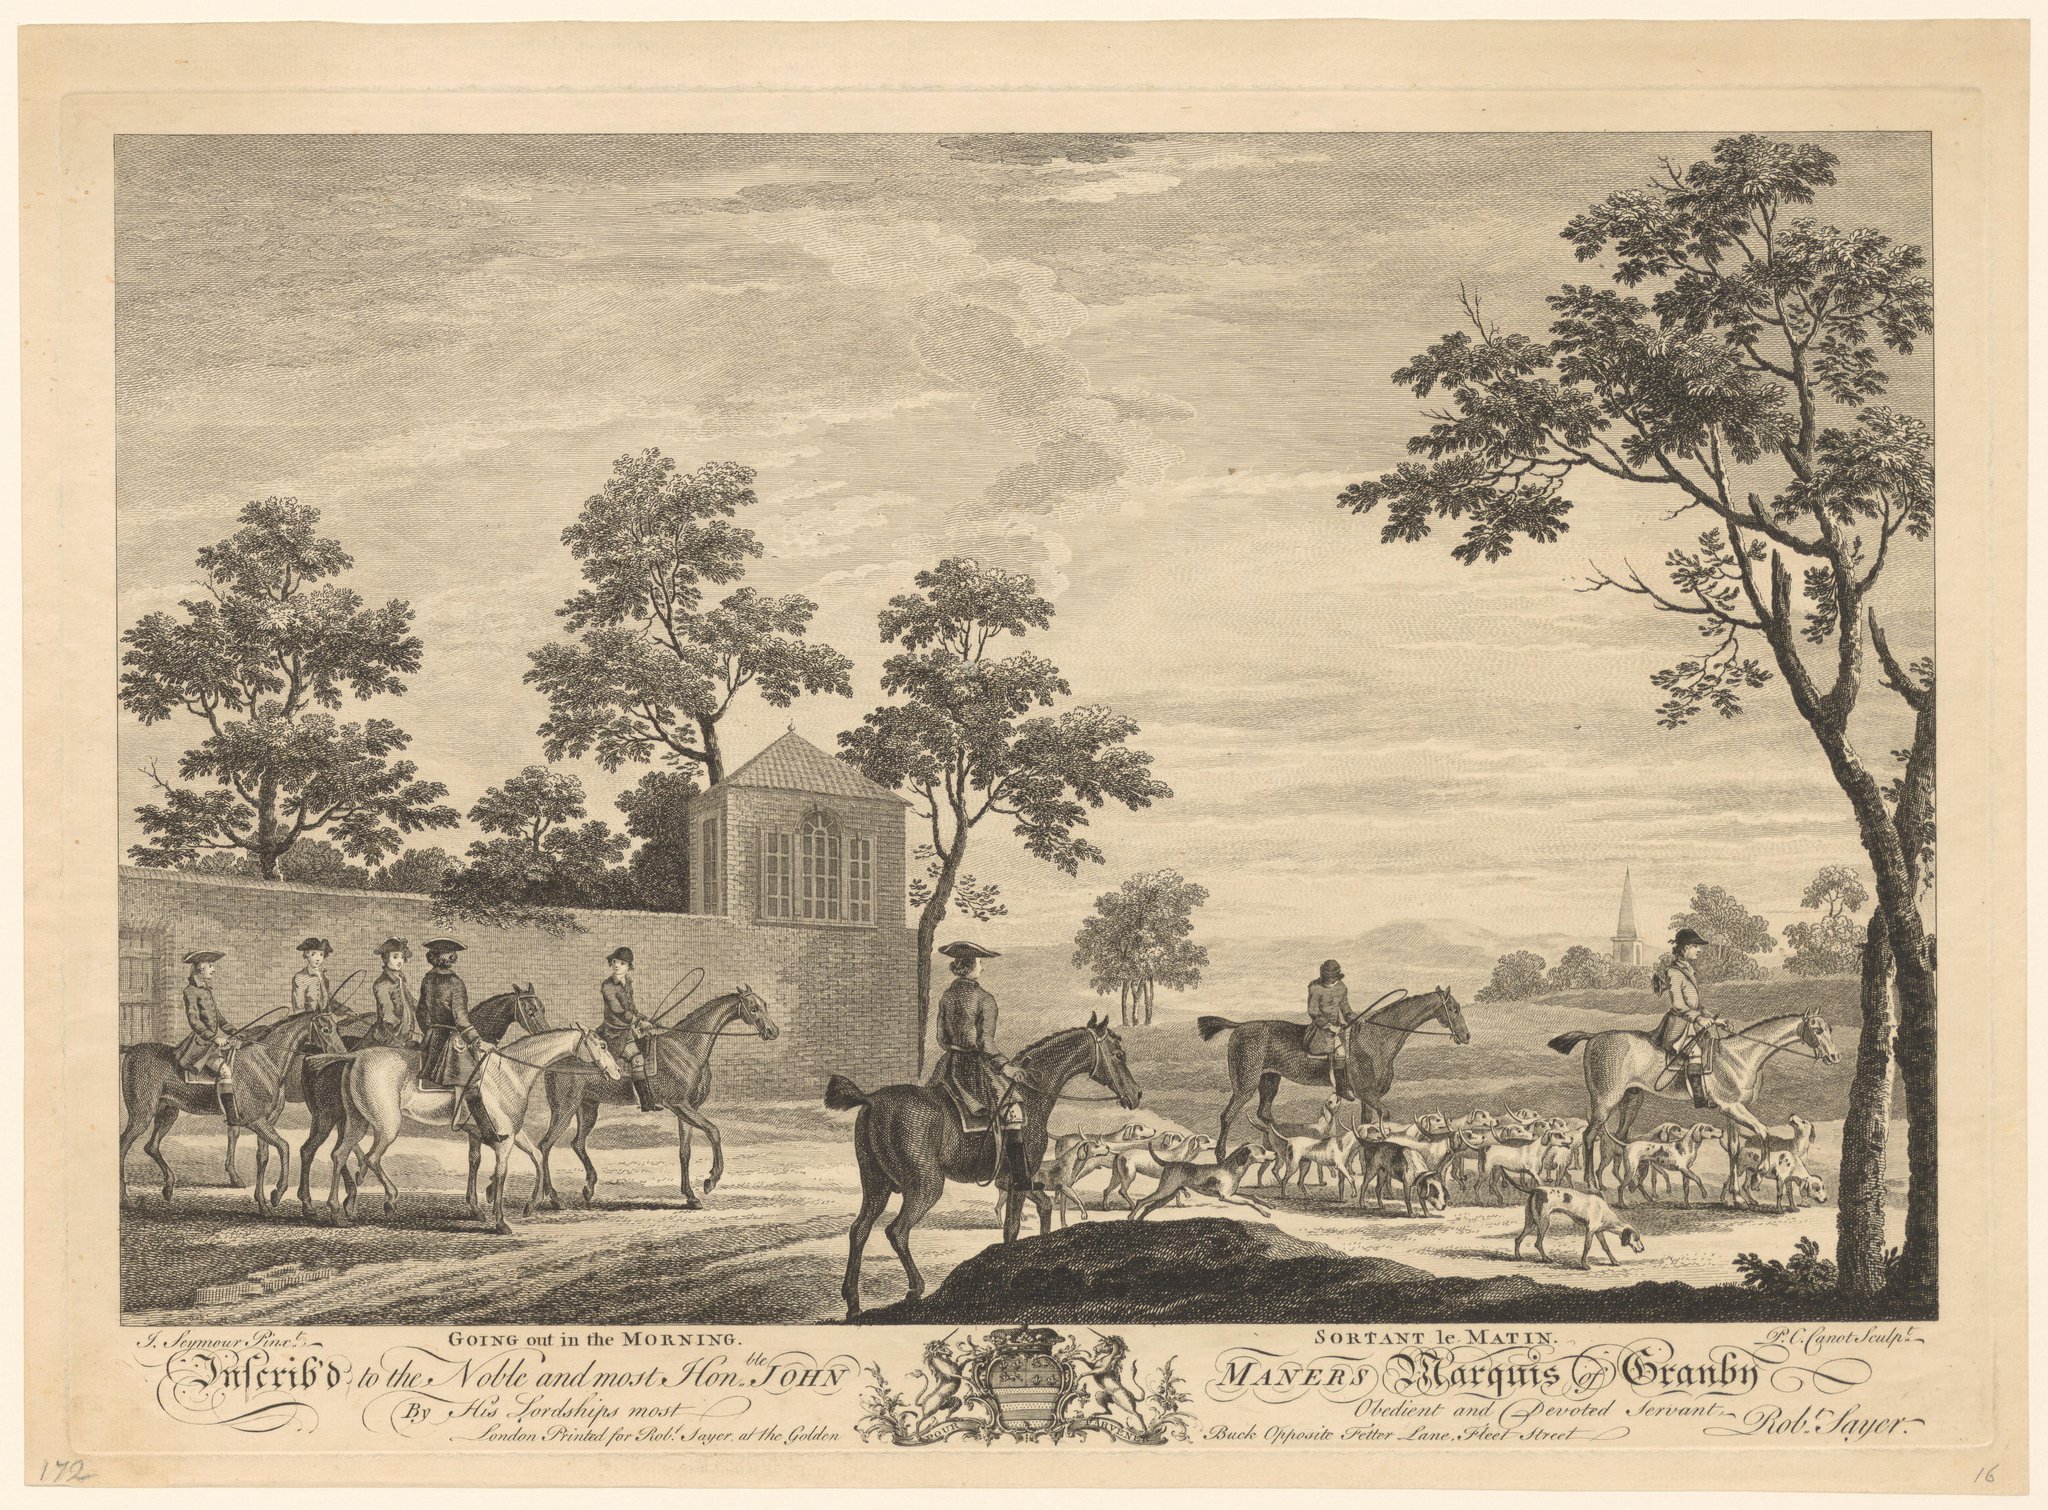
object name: print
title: Going out in the Morning / Sortant le Matin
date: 1745-1777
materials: paper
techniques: engraving, etching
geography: london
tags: hunting dogs, assembling, 'départ pour la chasse'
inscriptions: collector's mark: Lugt 2228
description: Tekst in het Engels en in het Frans in de ondermarge.